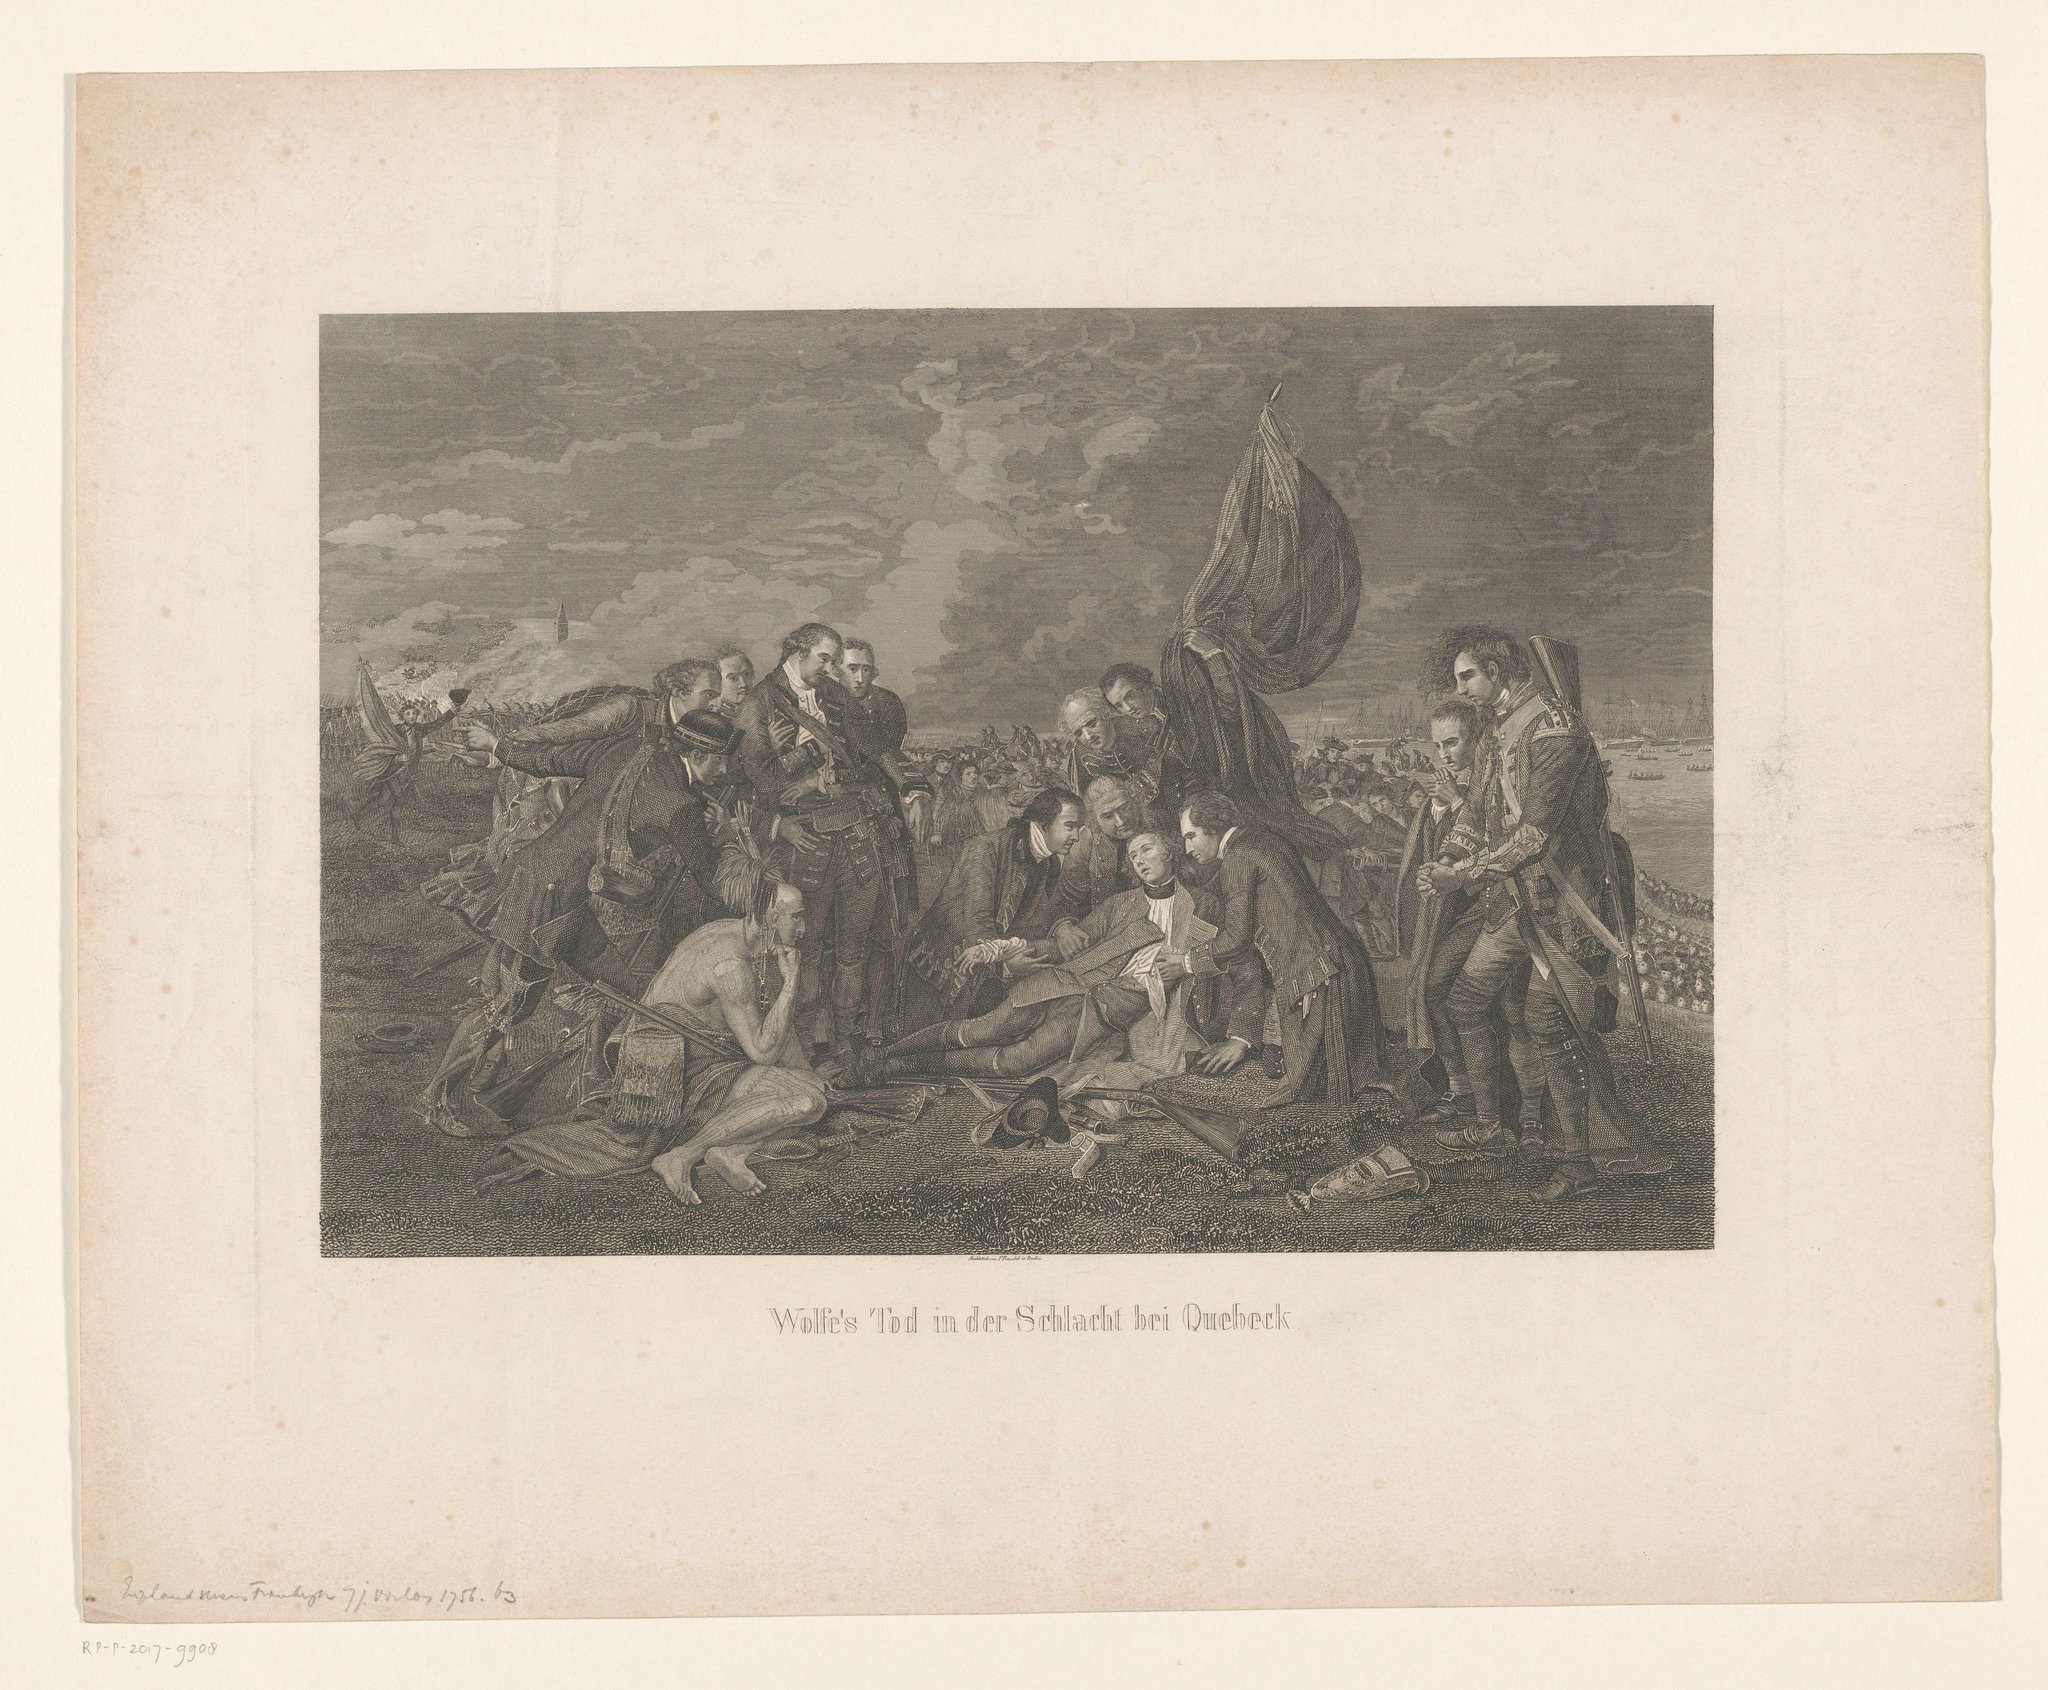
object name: print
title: Wolfe's Tod in er Schlacht bei Quebeck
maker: friedrich randel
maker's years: 1808-1886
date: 1818-1886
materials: paper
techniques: engraving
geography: berlin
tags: indigenous peoples of north america, dying, battle (+ land forces), québec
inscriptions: collector's mark: Lugt 2228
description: De dood van de Engelse generaal James Wolfe op 13 september 1759 tijdens de slag om Quebec, onderdeel van de Zevenjarige Oorlog (1756-1763). De generaal stervend op de grond omringd door zijn troepen, een half naakte oorspronkelijke bewoner van Canada met lichaamstatoeages en verentooi kijkt toe, naast hem ligt een strijdbijl.